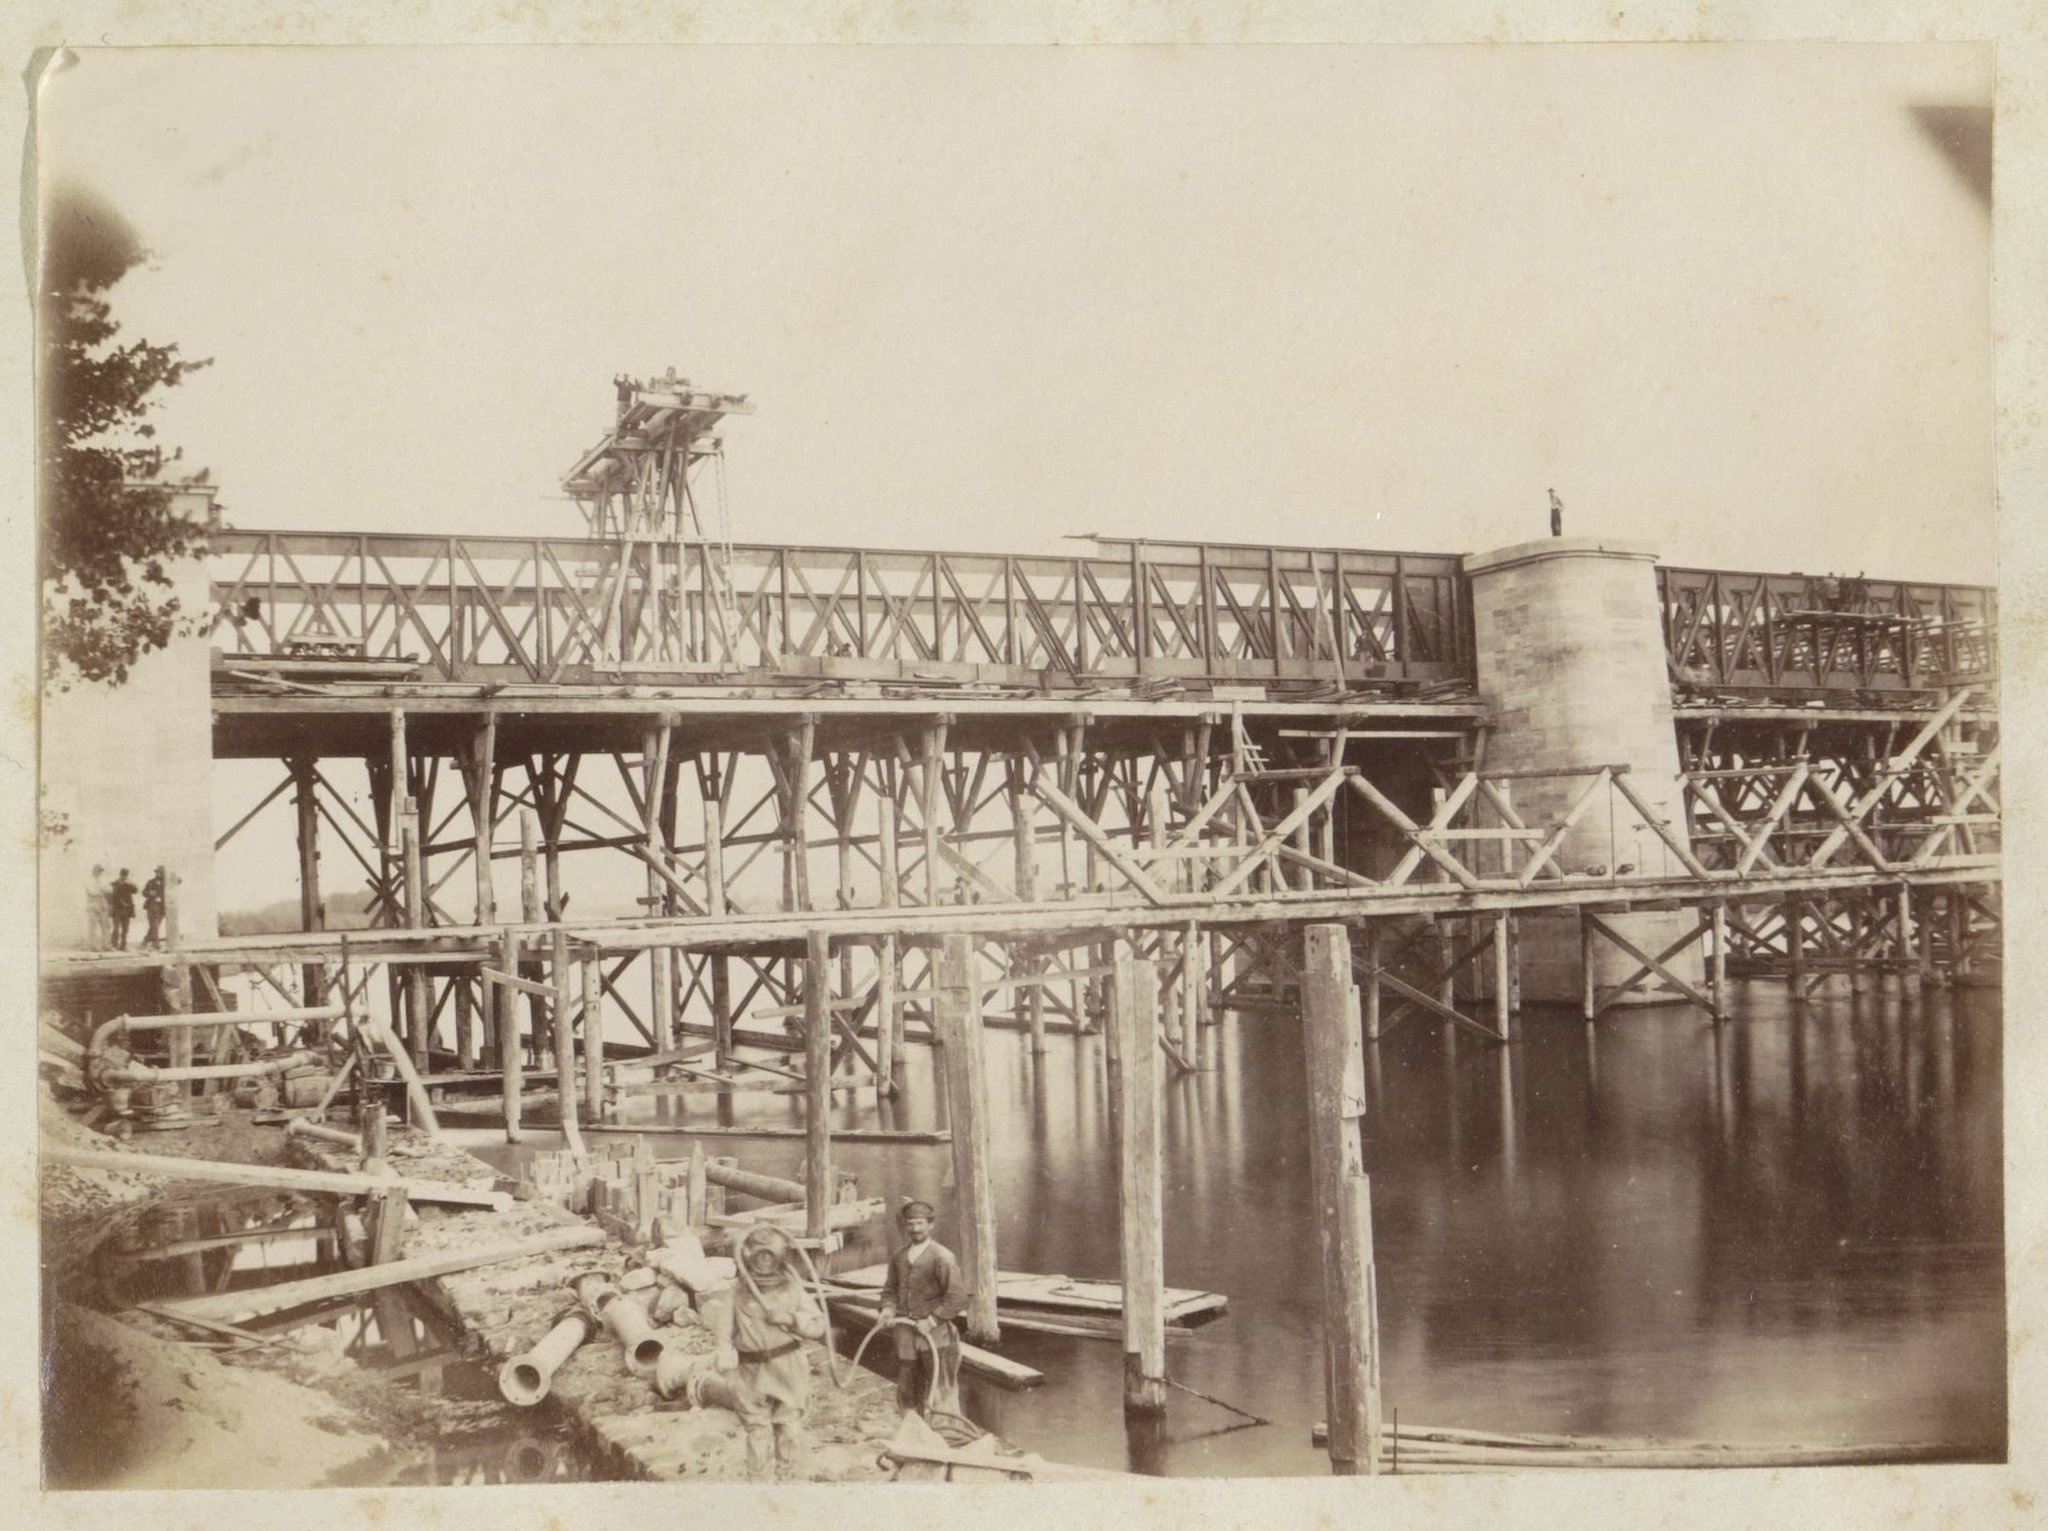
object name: photograph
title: Brug in aanbouw in Frankrijk, met op de voorgrond een duiker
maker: Anonymous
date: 1883-1886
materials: photographic support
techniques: albumen print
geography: france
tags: bridge, building-site, france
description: Onderdeel van Album van een Franse amateurfotograaf met opnames van familie, militairen, industrie, landschappen en bezienswaardigheden in Frankrijk.